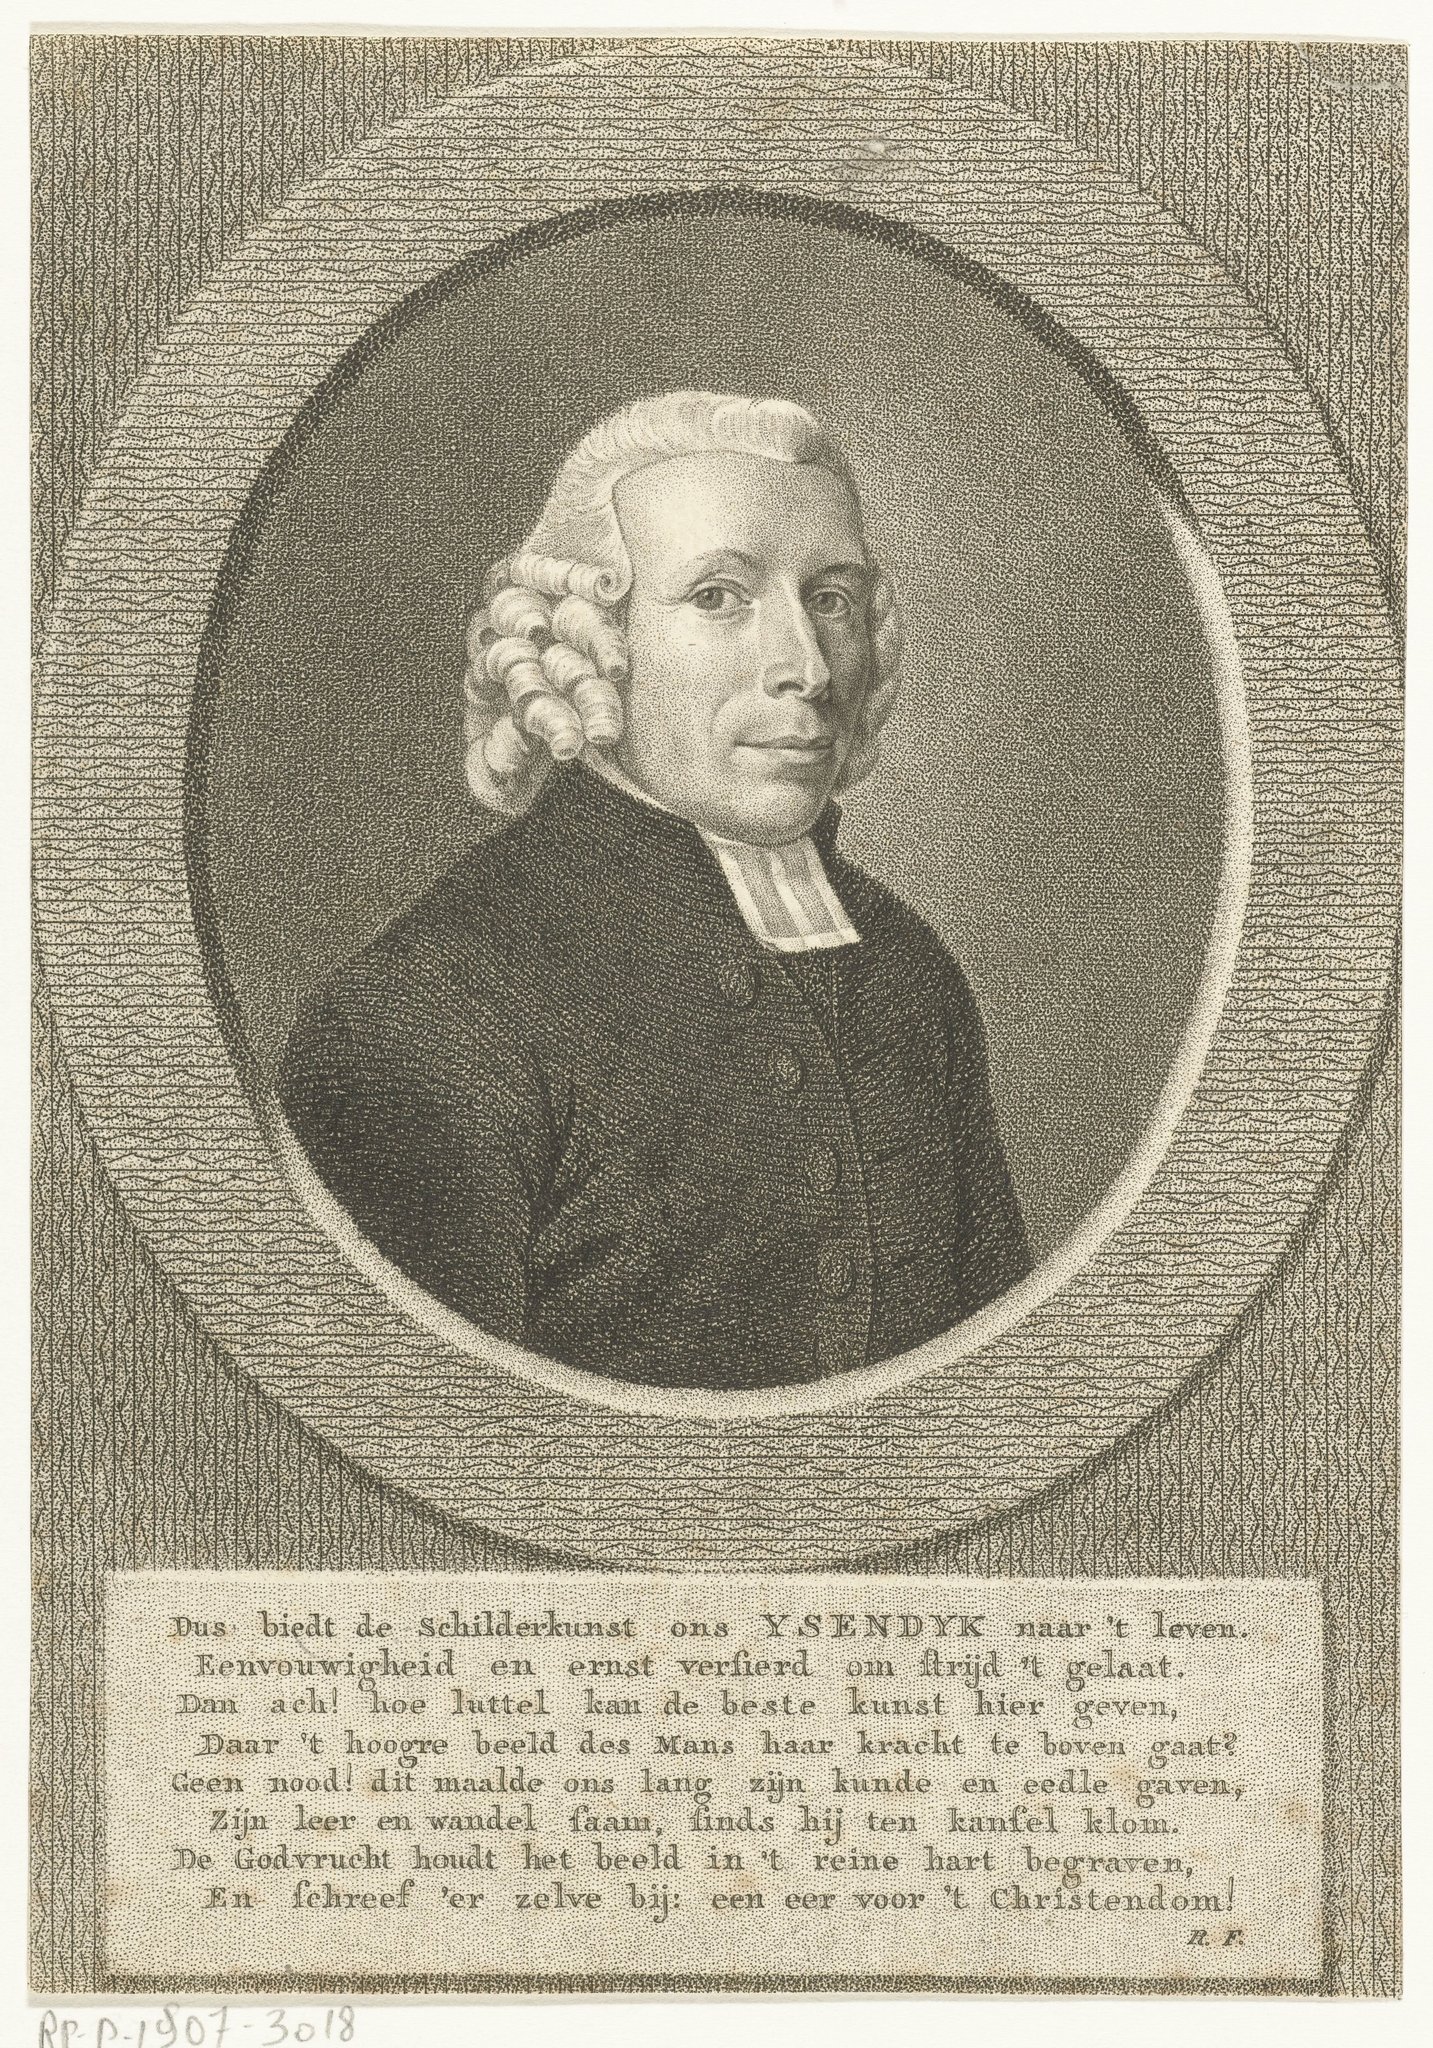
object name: print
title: Portret van Arent van Ysendyck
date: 1803-1829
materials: paper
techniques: etching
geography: amsterdam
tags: arent van ysendyck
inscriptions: collector's mark: Lugt 2166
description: Portret in ovale lijst van Arent van Ysendyck, een Amsterdamse prediker. Buste naar rechts. Van Ysendyck draagt een predikersgewaad. De prent heeft een Nederlands onderschrift met een gedicht en de naam van de geportretteerde.